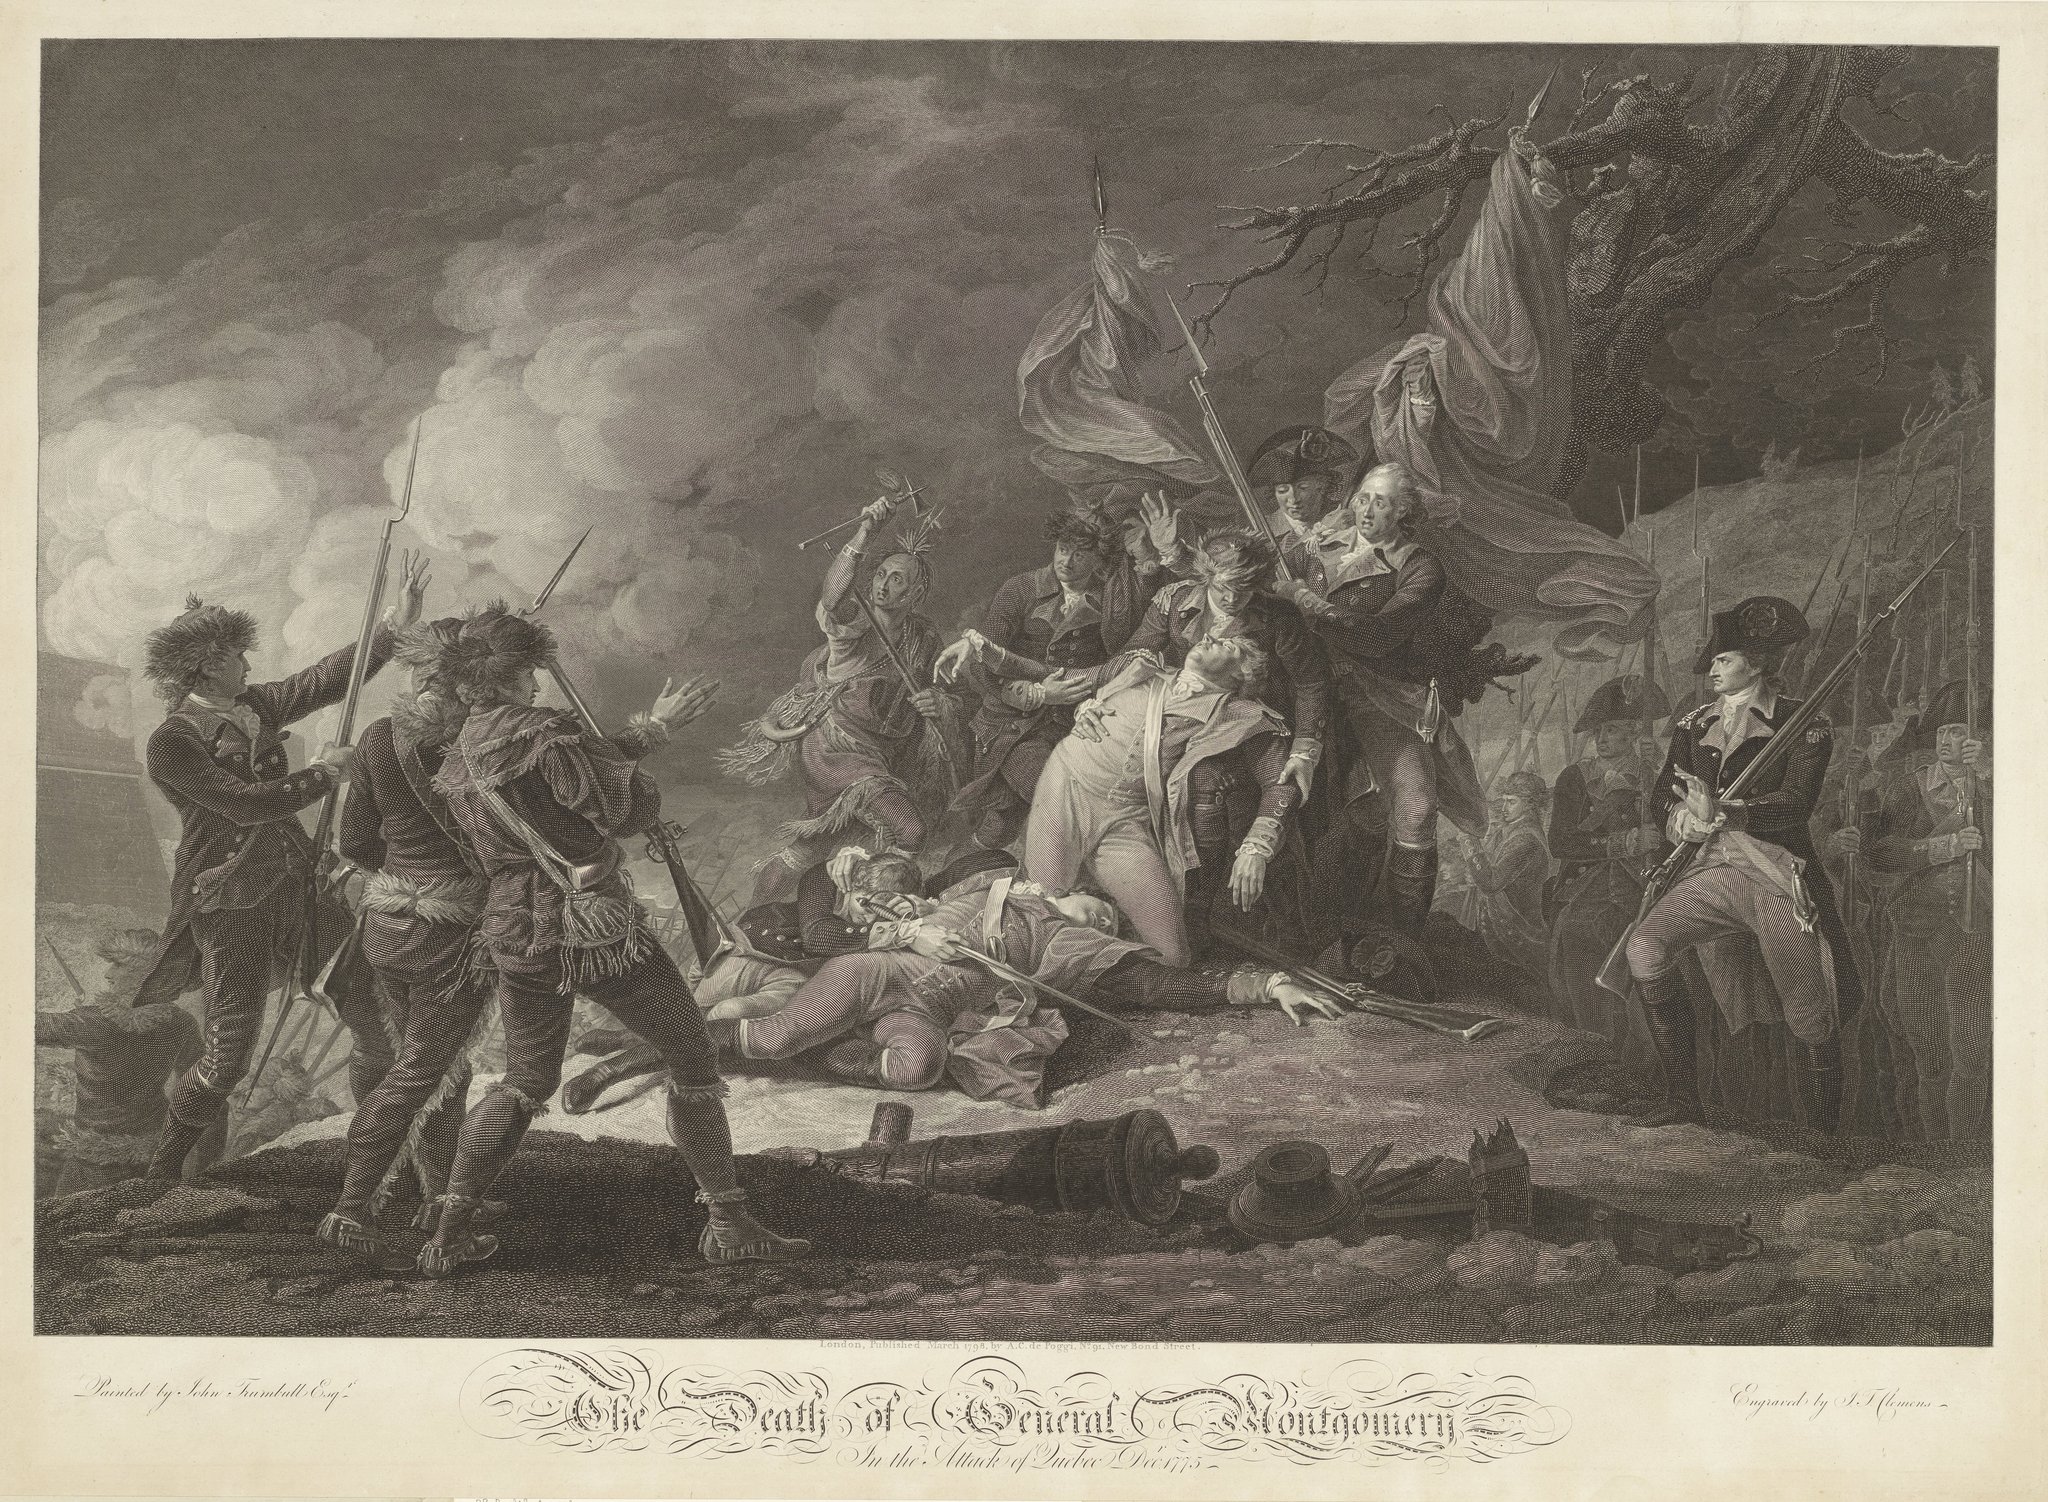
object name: print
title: The Death of Genereal Montgomery In the Attack of Quebex Dec. 1775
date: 1703-1798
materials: paper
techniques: engraving, etching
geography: london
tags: québec, commander-in-chief, general, marshal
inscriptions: collector's mark: Lugt 2228